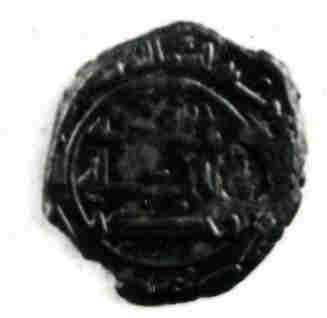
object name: coin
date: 770-772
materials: copper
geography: iran